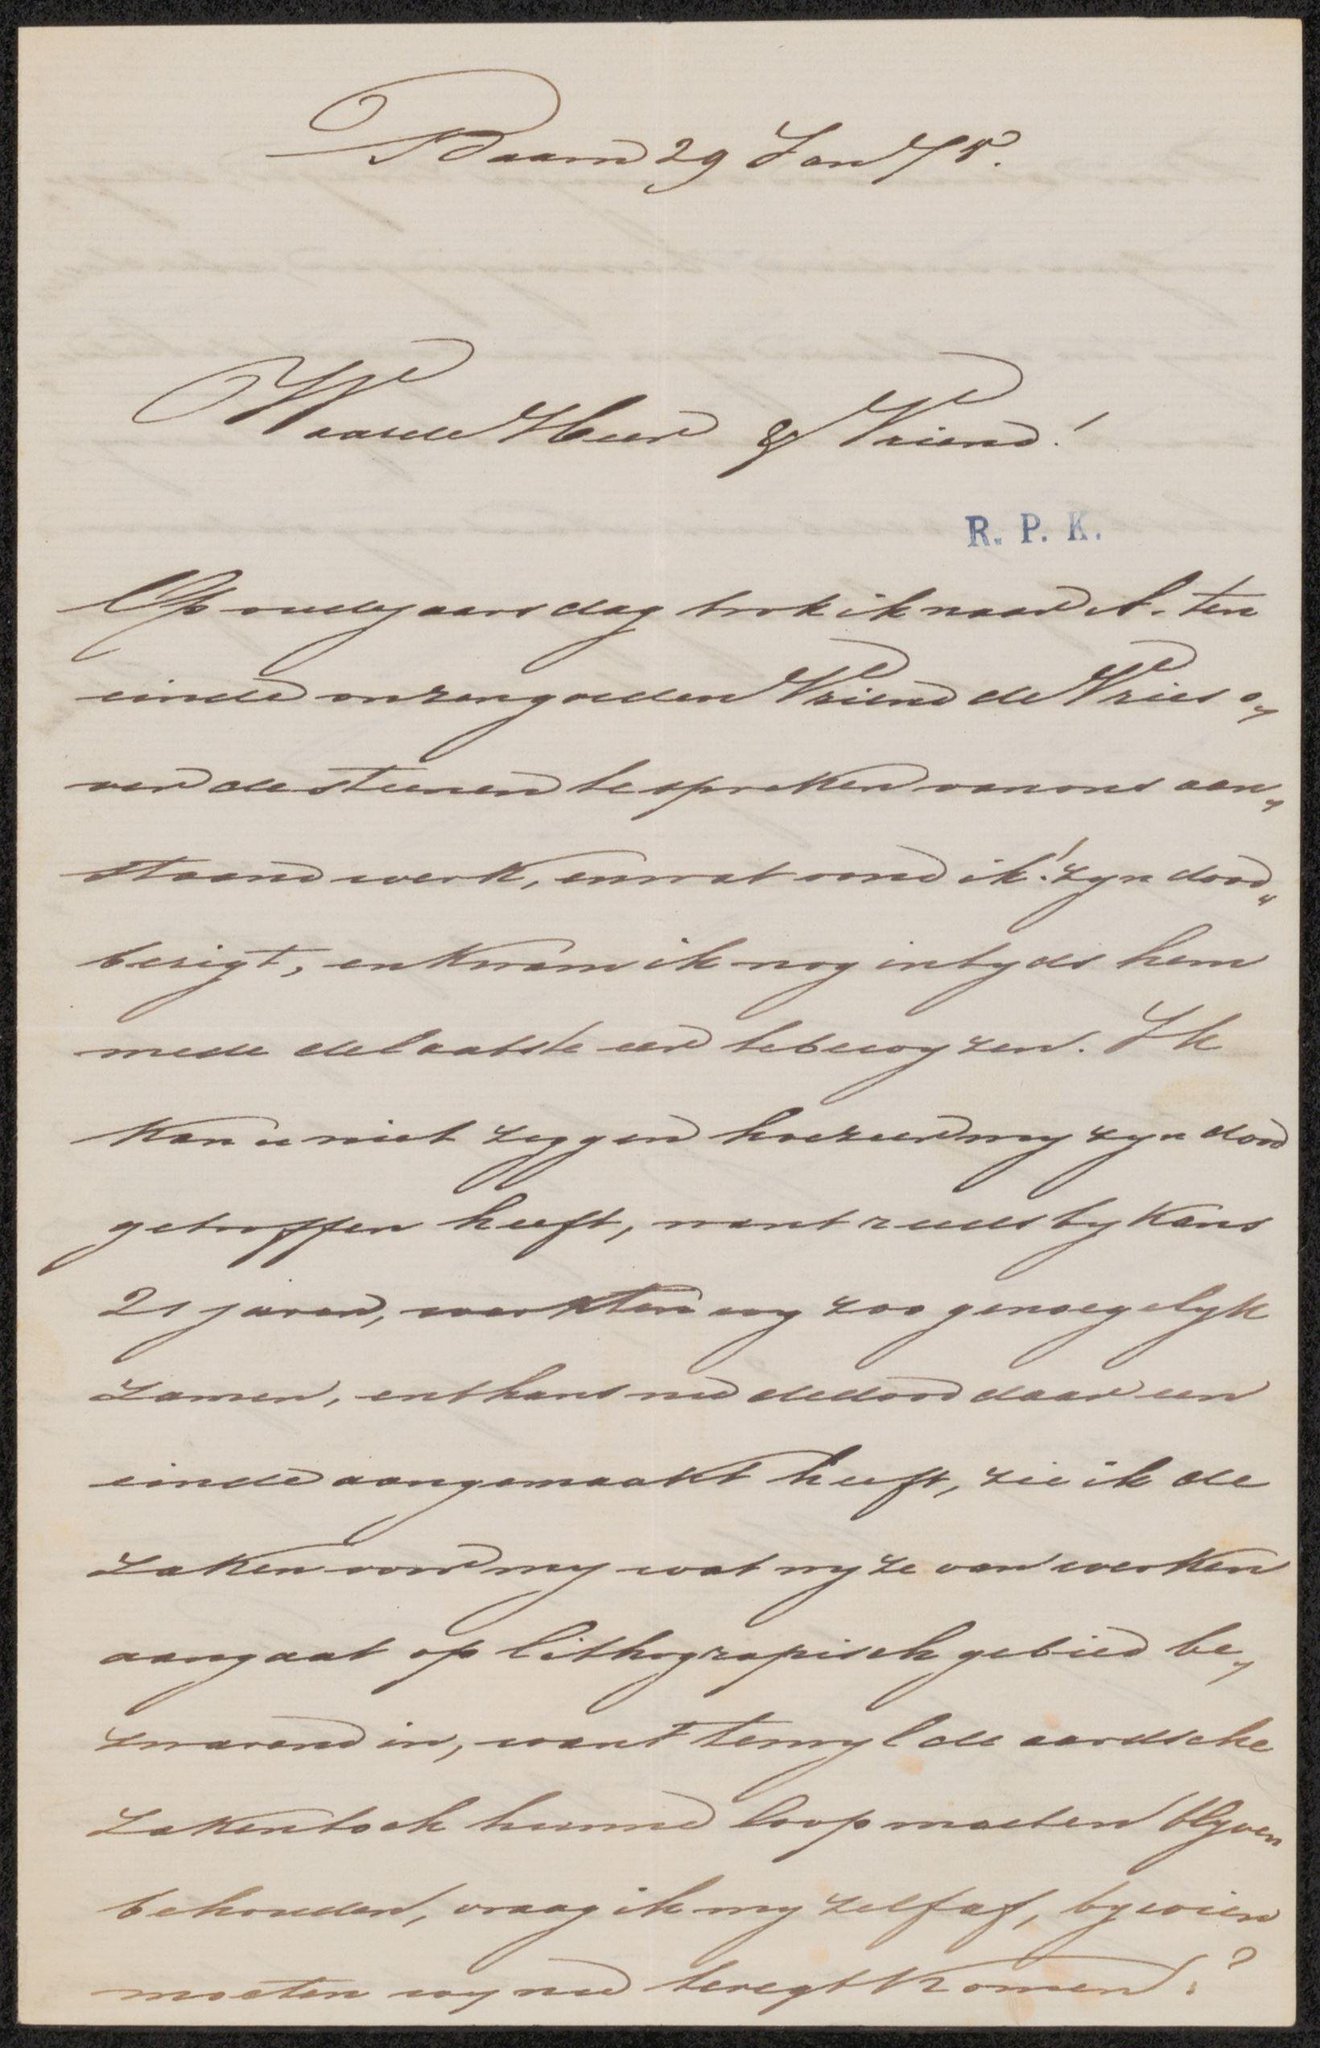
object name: letter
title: Brief aan Alberto Caramelli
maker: johan conrad greive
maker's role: draughtsman, painter, print maker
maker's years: 1837-1891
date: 1875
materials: ink, paper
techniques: pen, writing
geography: baarn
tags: utrecht, alberto caramelli, ruurt de vries, family life, painting (including book-illumination, miniature-painting), printed matter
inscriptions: collector's mark: Lugt 2233